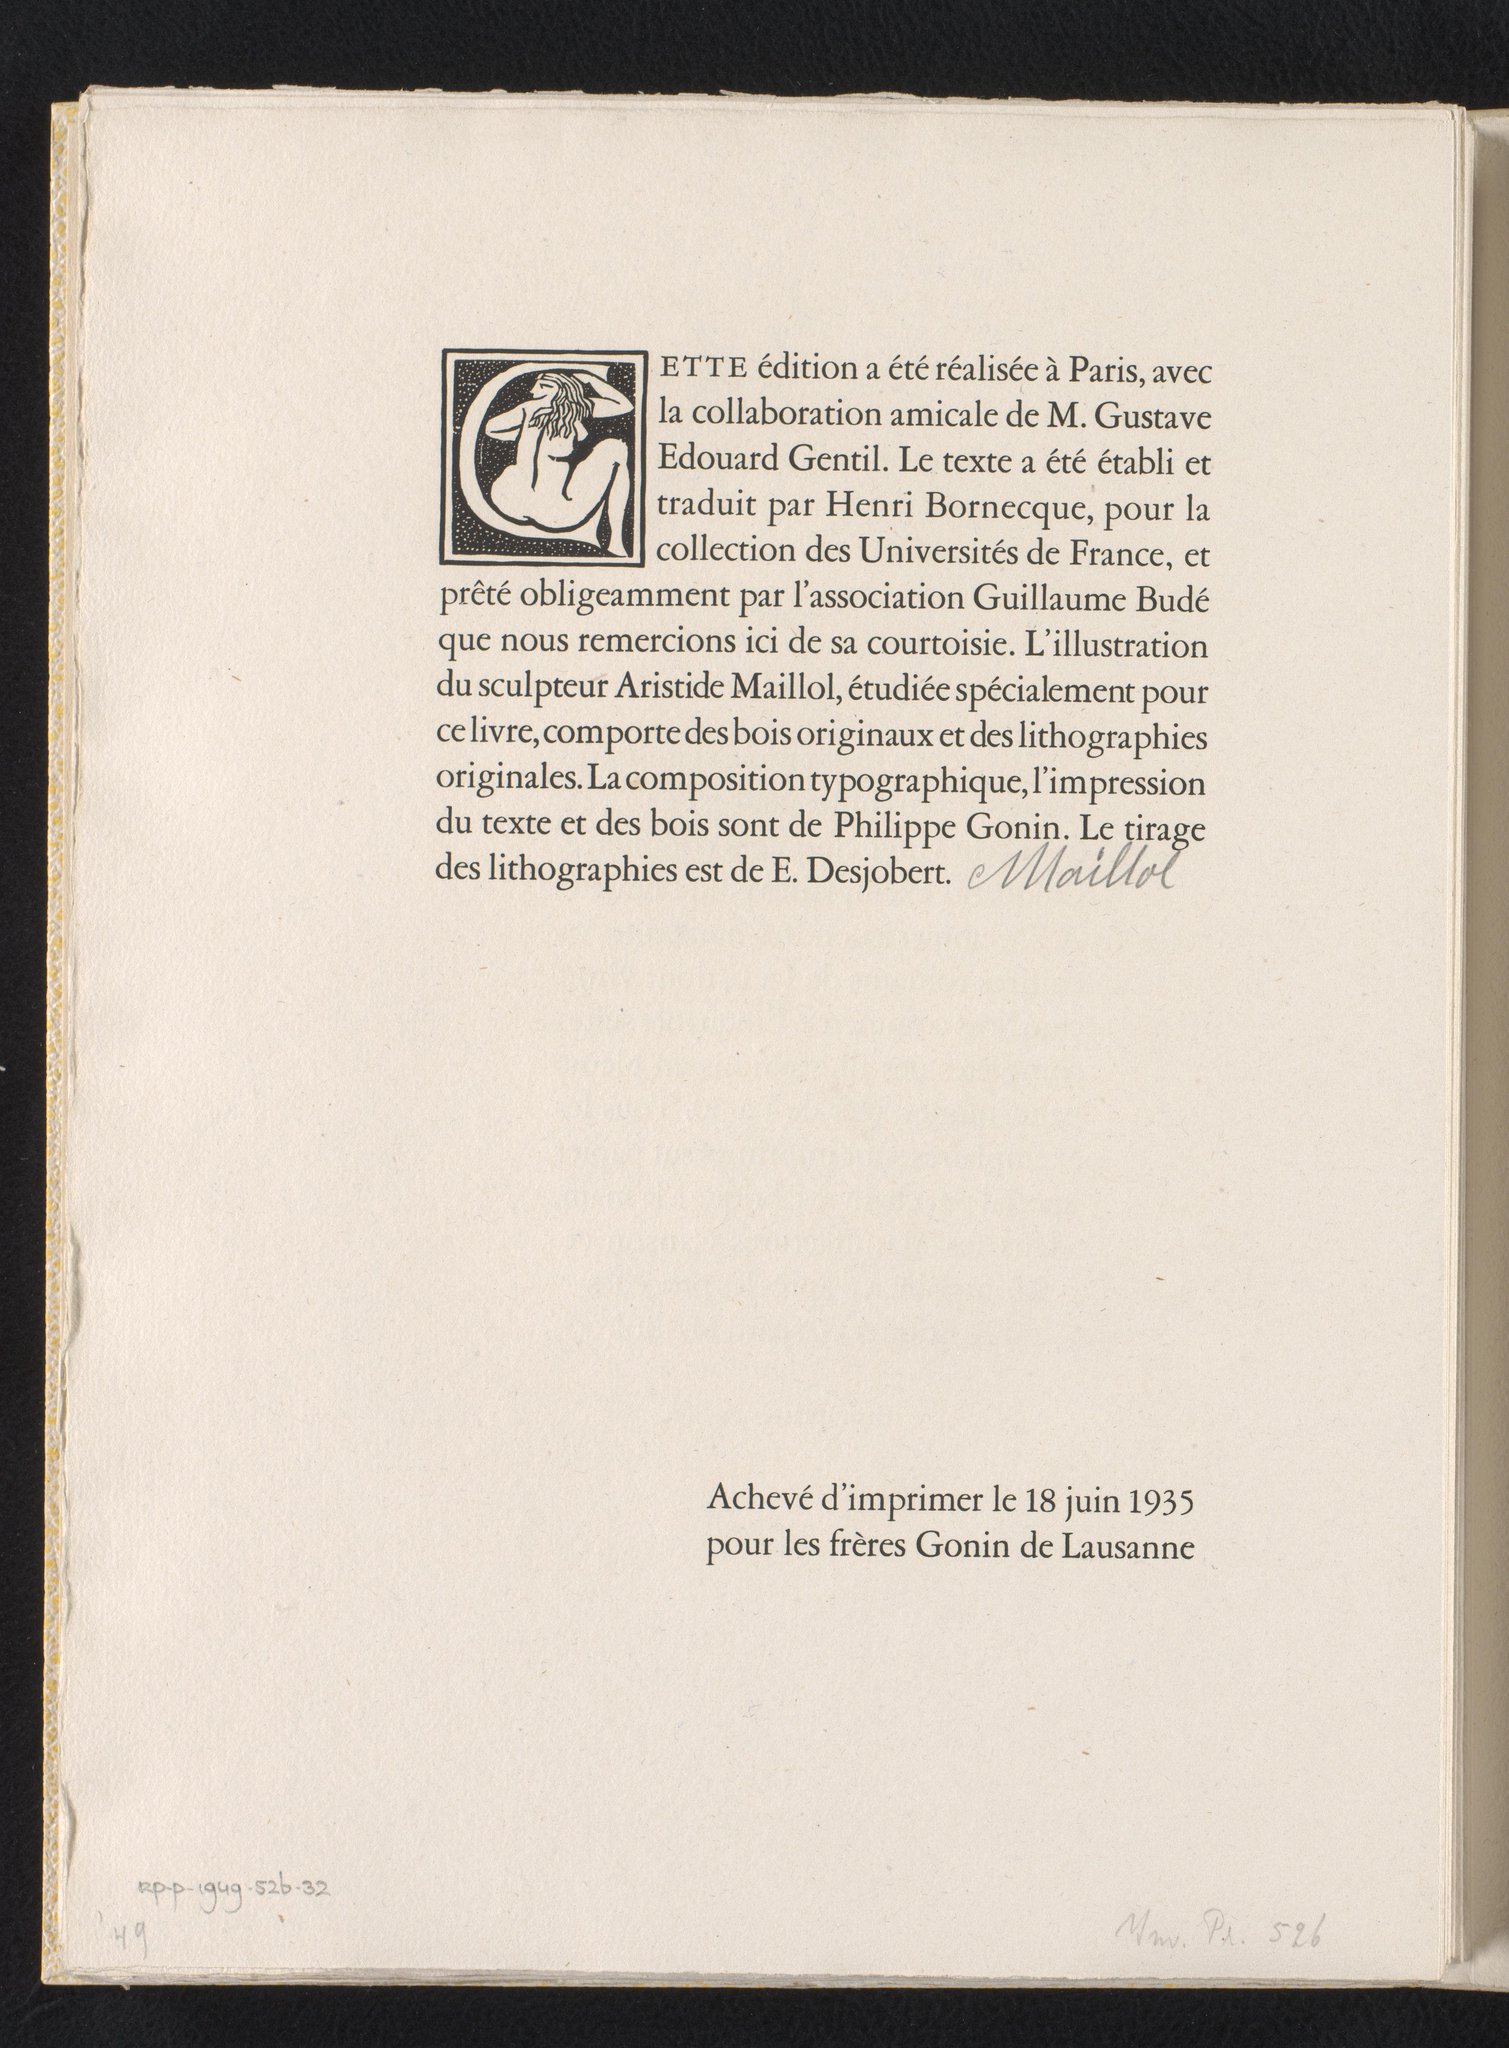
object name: book illustration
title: Liggende naakte man met hert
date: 1935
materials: paper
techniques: letterpress printing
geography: lausanne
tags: initial, woman (showing herself) undressed, quasi-nude, sitting on an elevation - aa - female human figure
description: Prent in: Ovidius Naso, Publius. L'art d'aimer. [Vertaald uit het Latijn door] Henri Bornecque. Parijs/Lausanne: Les frères Gonin, 1935, boven colofon.